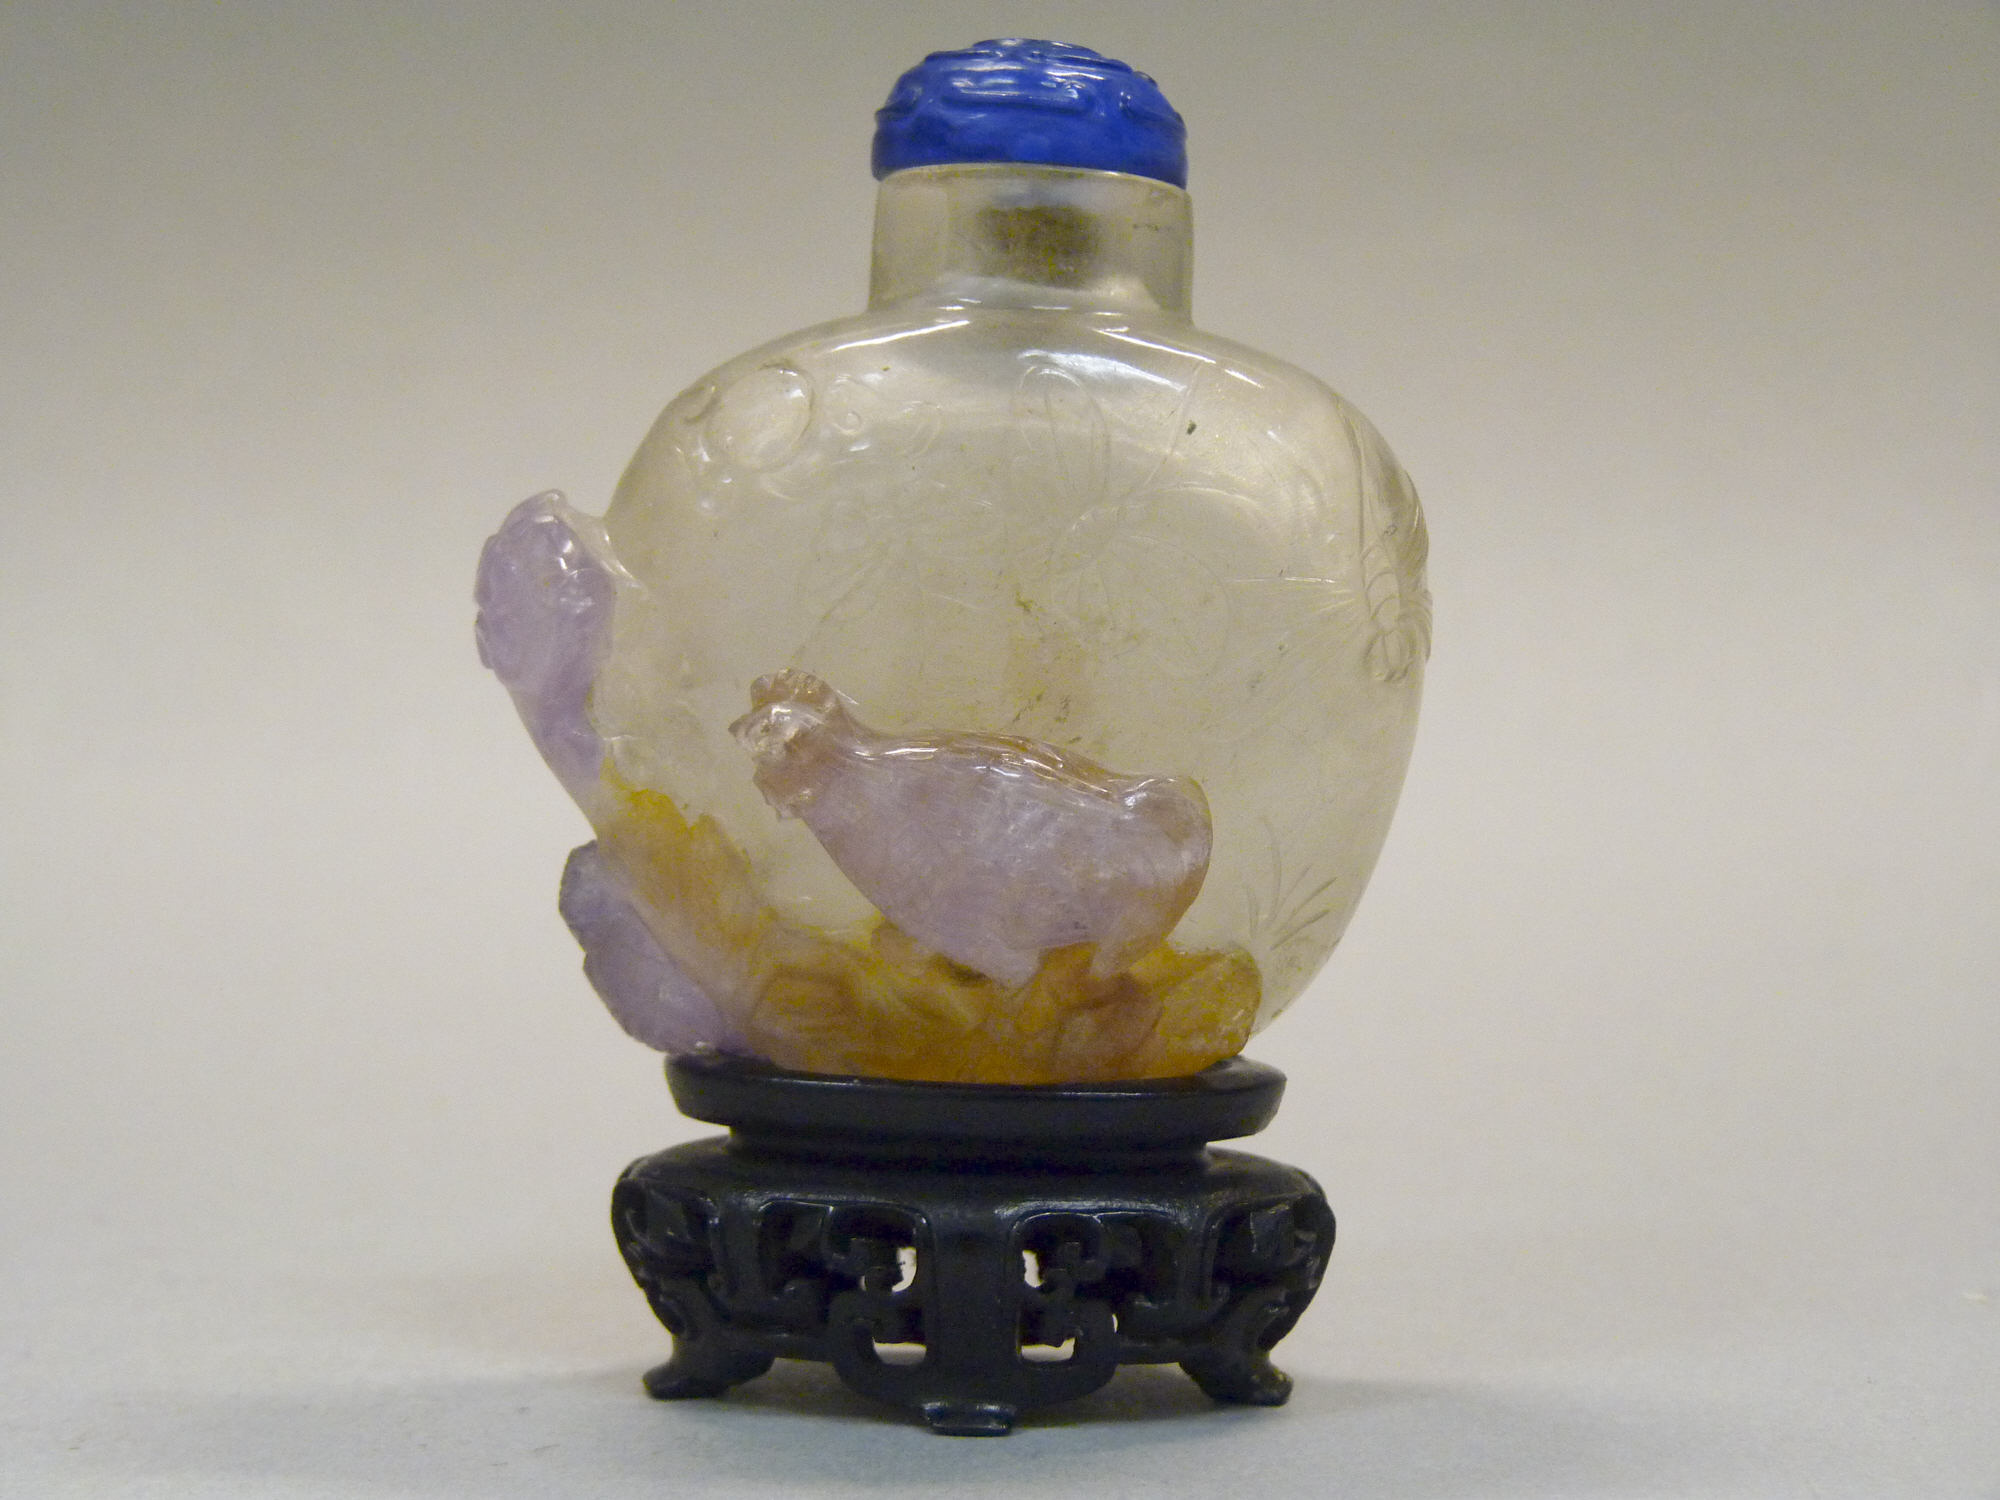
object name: snuff bottle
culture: chinese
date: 1736-1795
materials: gemstone, crystal, glass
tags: chickens